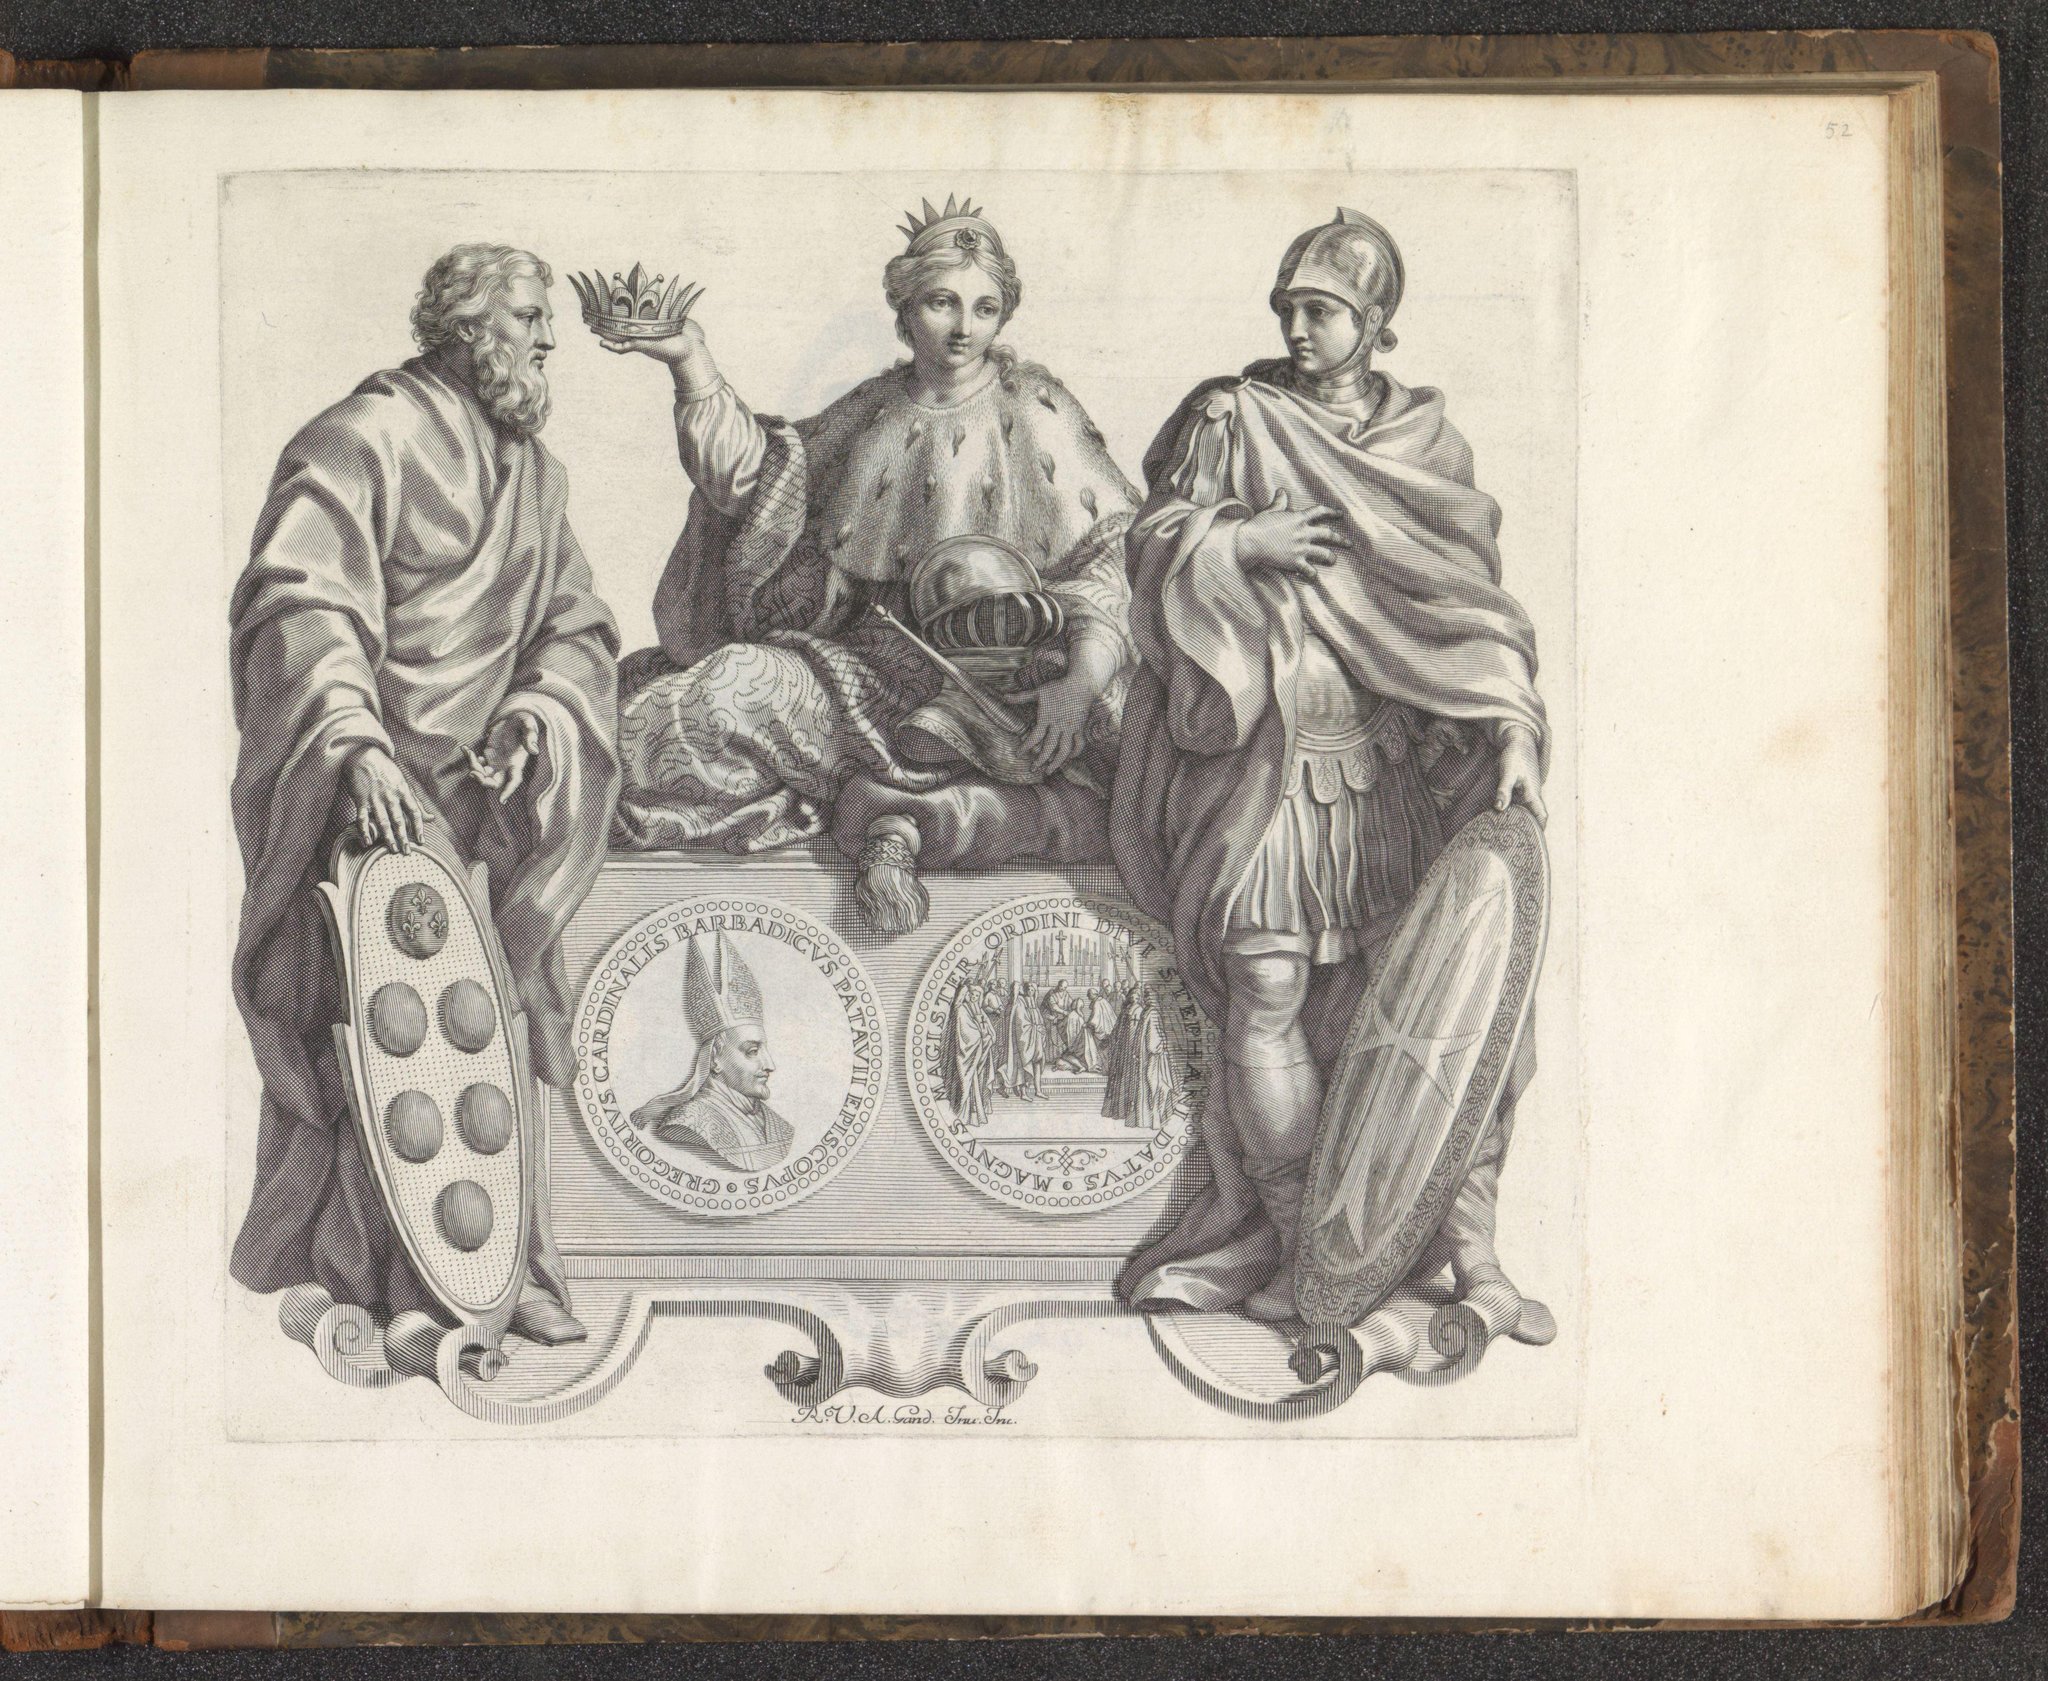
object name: album leaf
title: Numismata virorum illustrium ex Barbadica gente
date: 1673-1743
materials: paper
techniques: engraving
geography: rome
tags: cosimo iii de' medici, coat of arms (as symbol of the state, etc.), crown (symbol of sovereignty), insignia of bishop, e.g. mitre, crozier, medal (considered as a piece of sculpture, regardless of its specific function)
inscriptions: collector's mark: Lugt 2228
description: Voetstuk in de vorm van een cartouche. Daarop een medaillon met op de voorkant het portret van Gregorio Barbarigo. Hij draagt een mijter op zijn hoofd. Op de achterkant wordt Gregorio geïnstalleerd als grootmeester in de heilige en militaire orde van Sint-Stefanus door Cosimo III de' Medici. Het voetstuk wordt geflankeerd door een man in toga met het wapen van de' Medici en een geharnaste man met het wapen van de orde van Sint-Stefanus. De vrouw in het midden draagt een hermelijnen mantel en een kroon. Ze heeft een helm en scepter in haar handen en houdt een kroon met Franse lelie naast het hoofd van de' Medici. De prent maakt deel uit van een album.